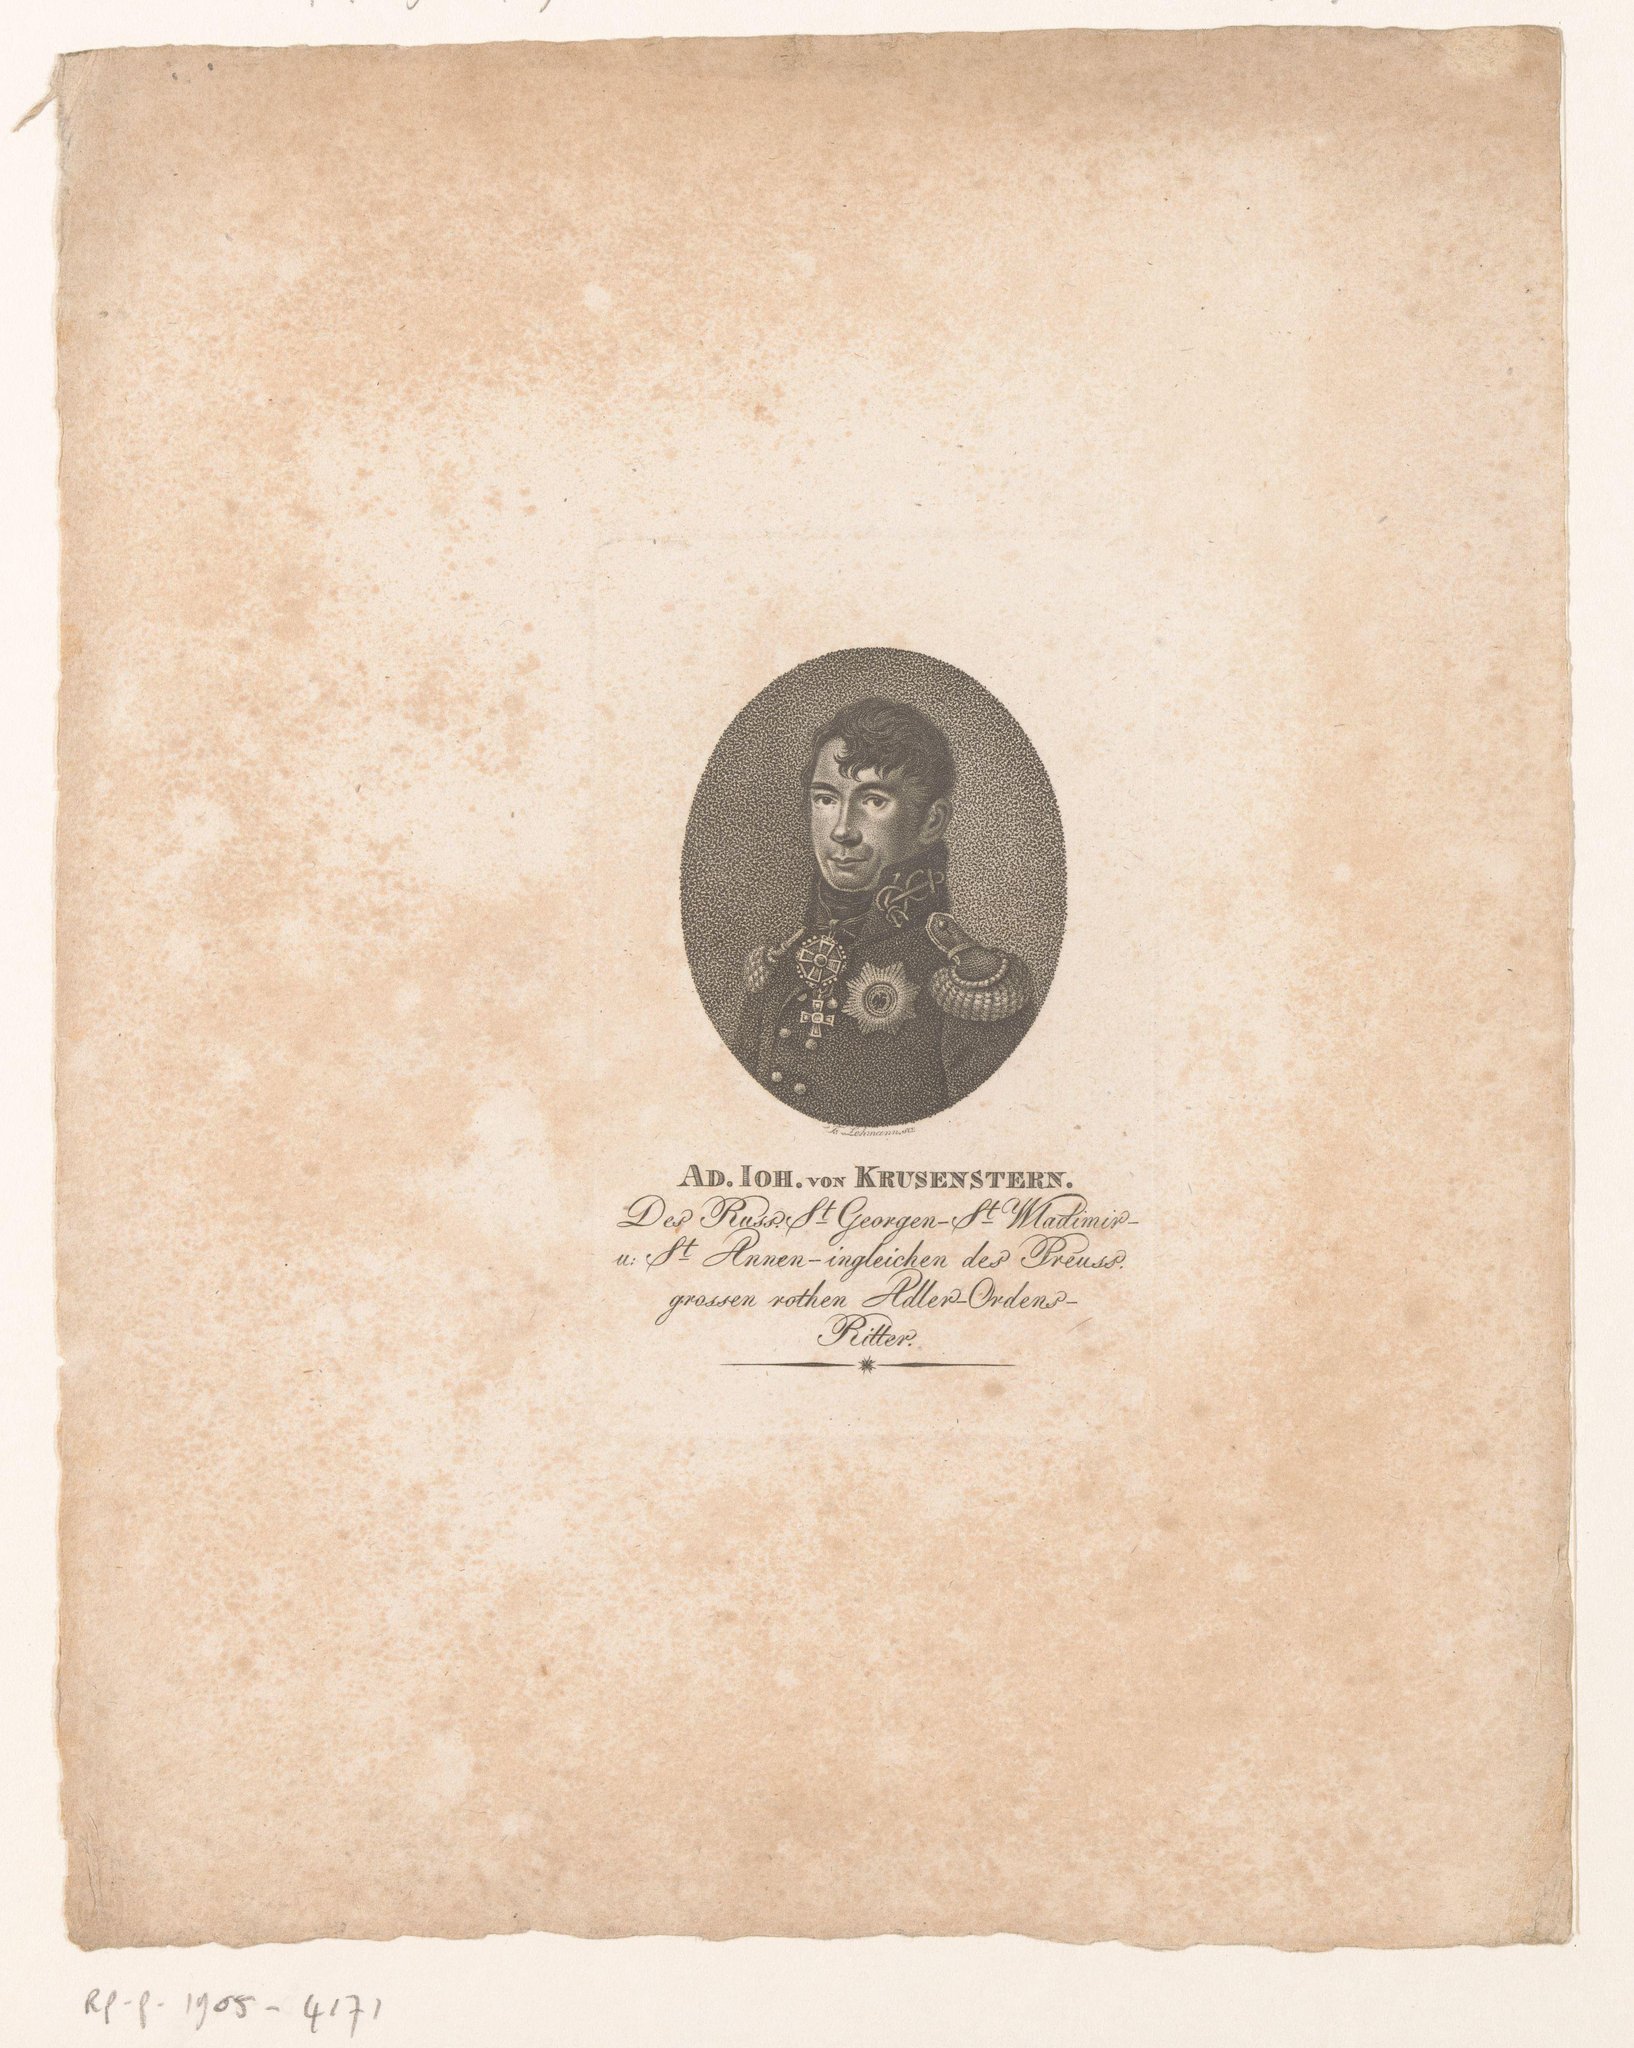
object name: print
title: Portret van Adam Johann von Krusenstern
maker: friedrich leonhard lehmann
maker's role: print maker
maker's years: 1787-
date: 1797-1886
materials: paper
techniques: engraving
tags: knighthood order (red eagle order), historical persons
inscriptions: collector's mark: Lugt 2228